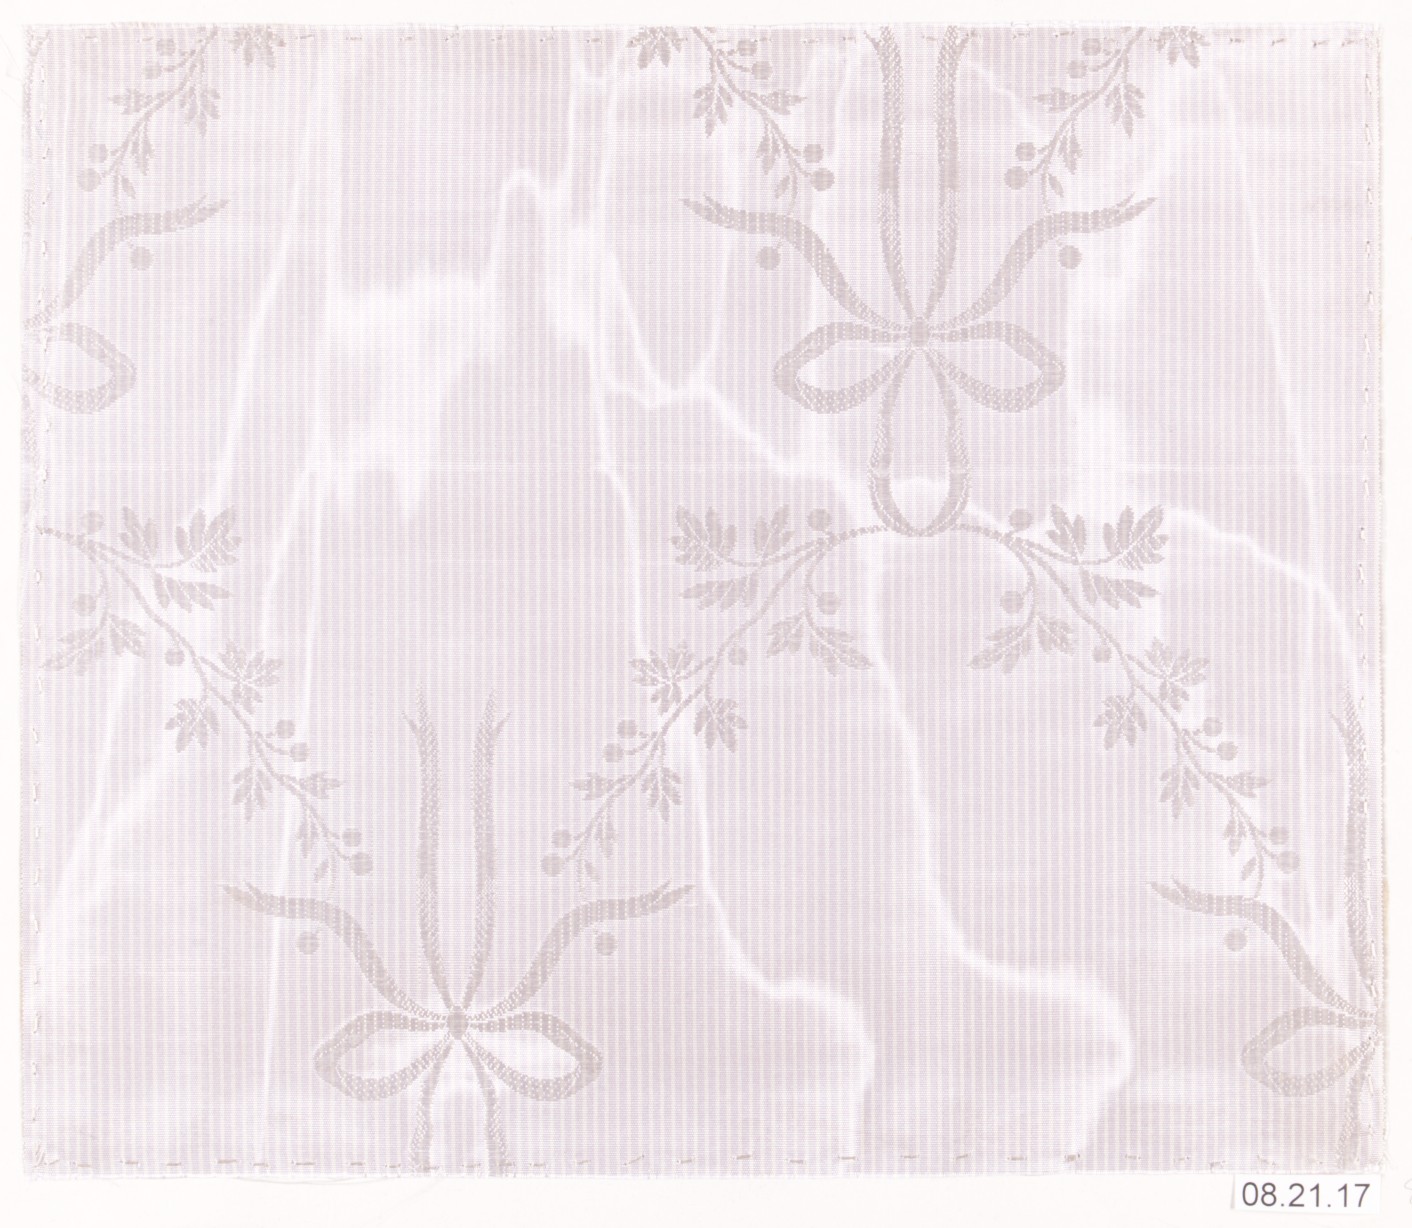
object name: textile sample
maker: Anonymous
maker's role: designer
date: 1900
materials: silk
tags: flowers